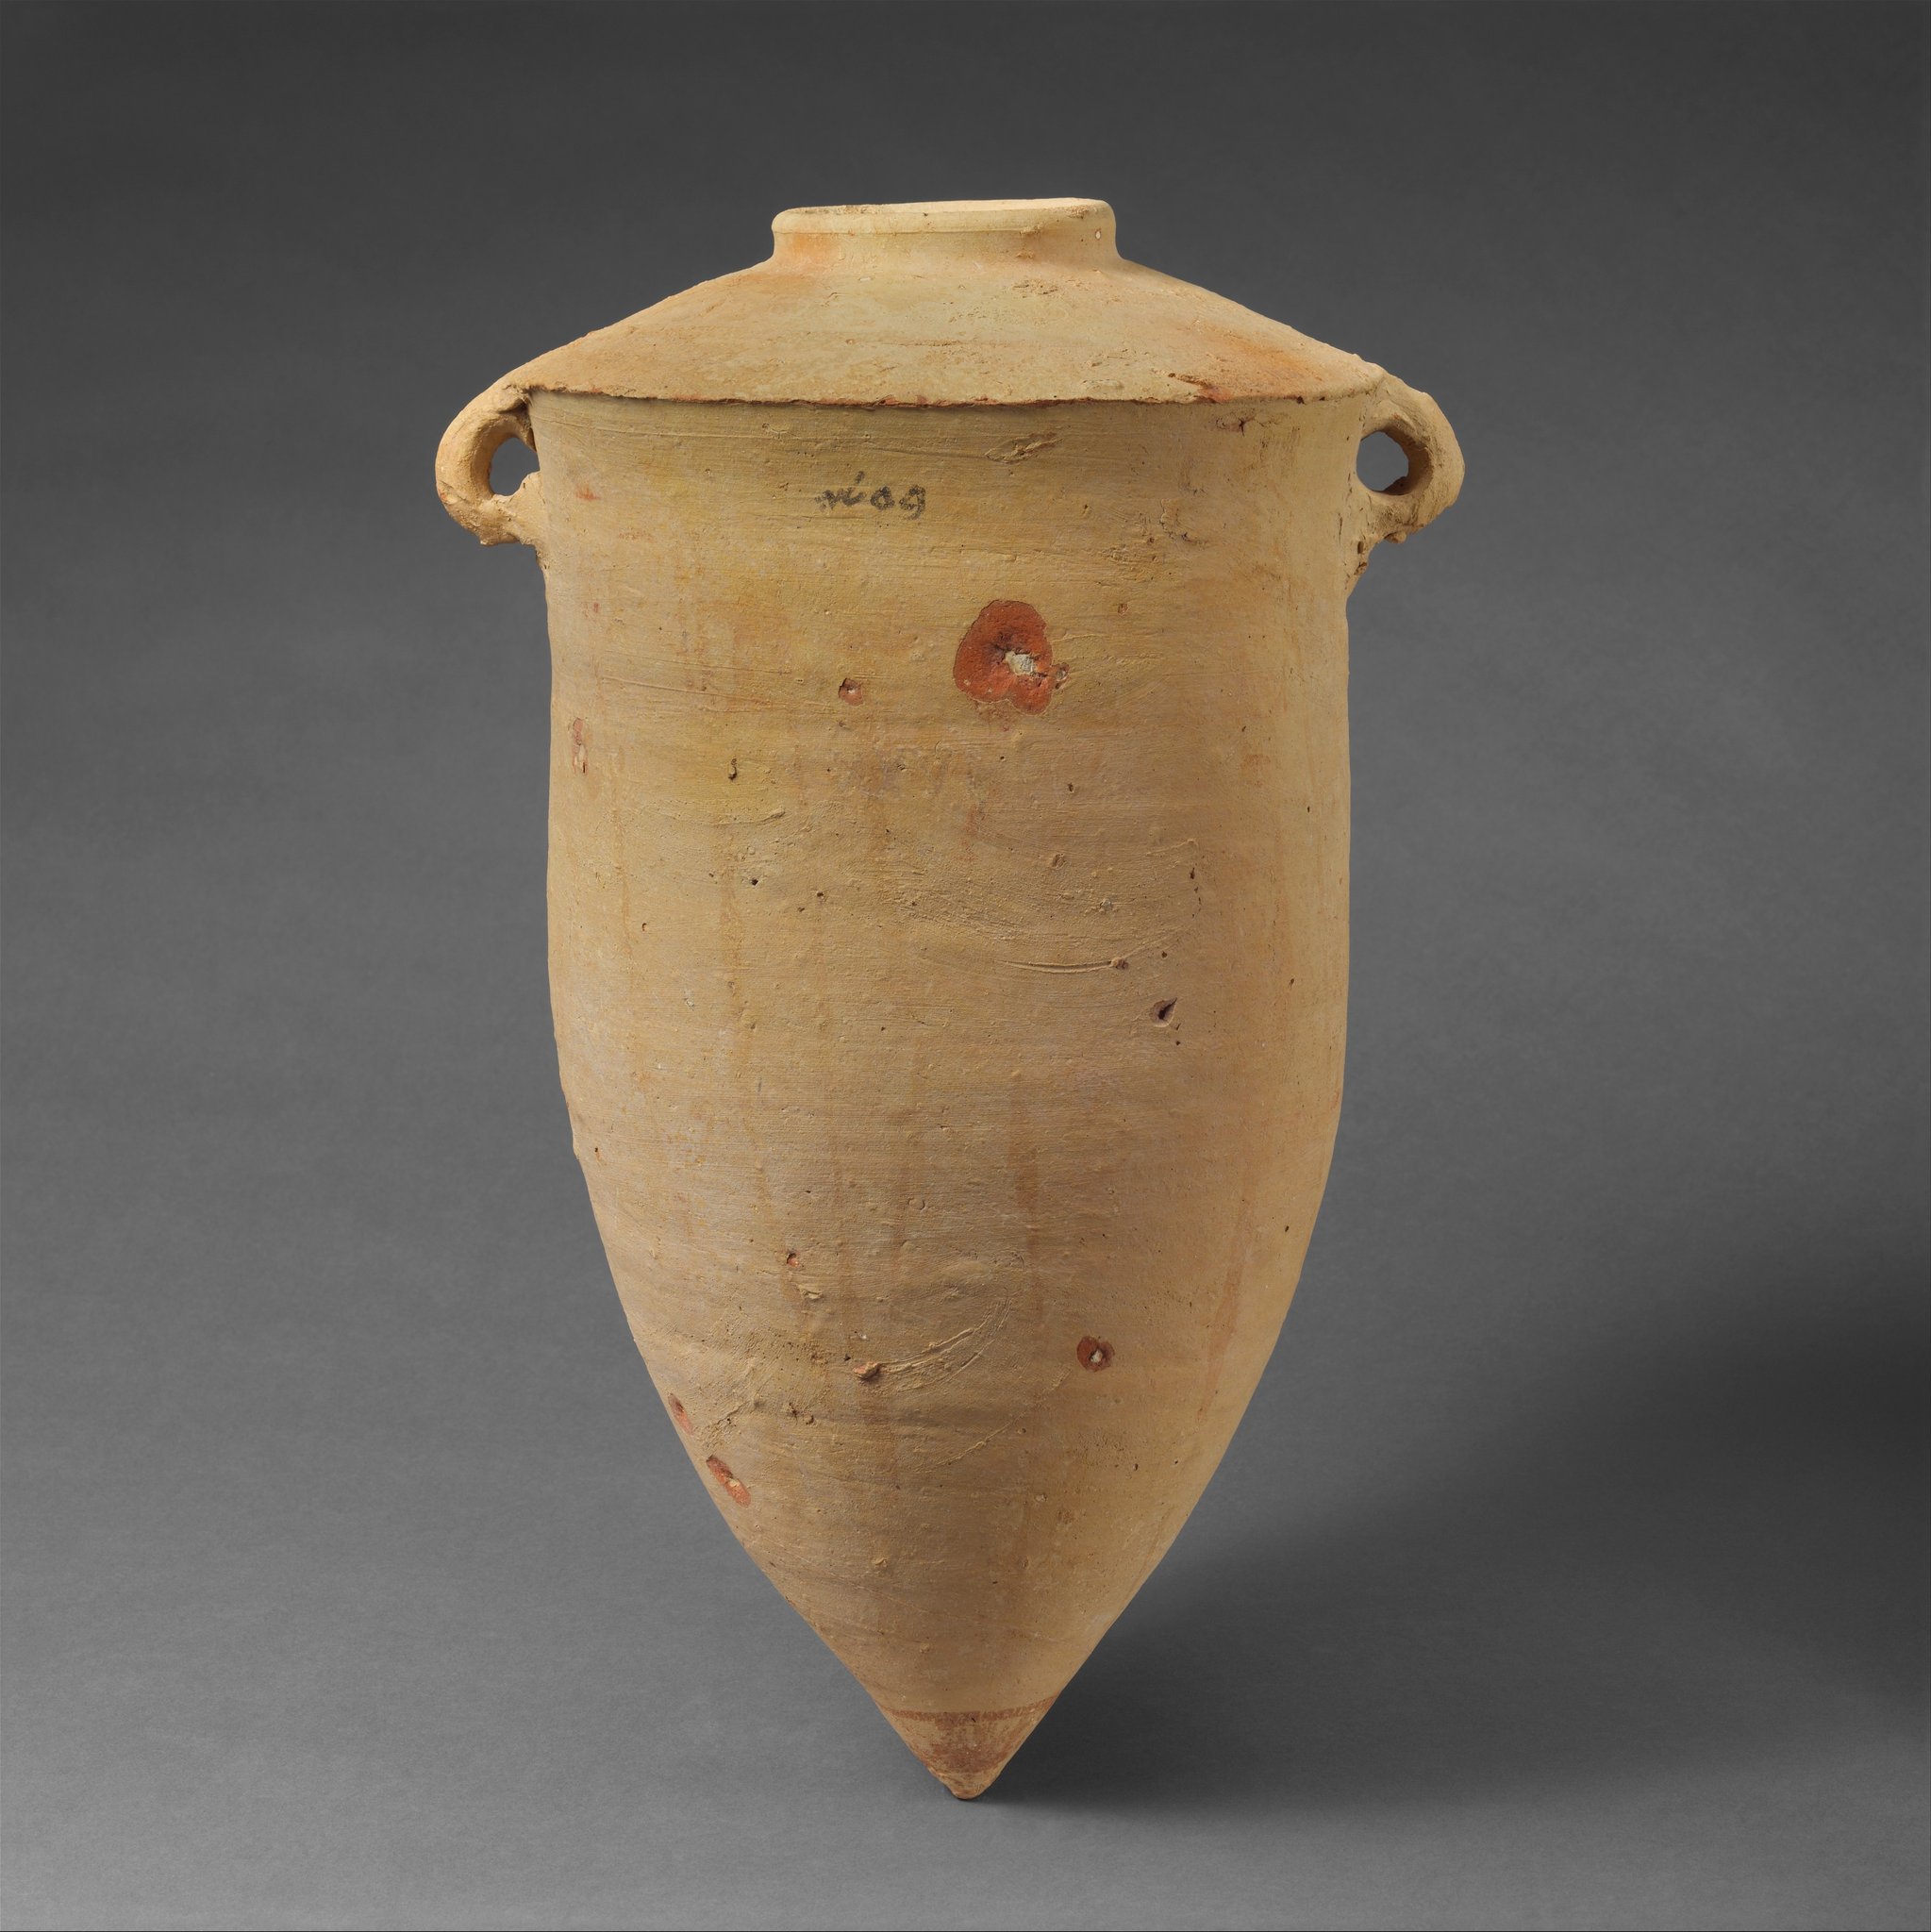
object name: amphora with phoenician inscription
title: Terracotta amphora with Phoenician inscription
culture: cypriot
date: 650-601 BCE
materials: clay